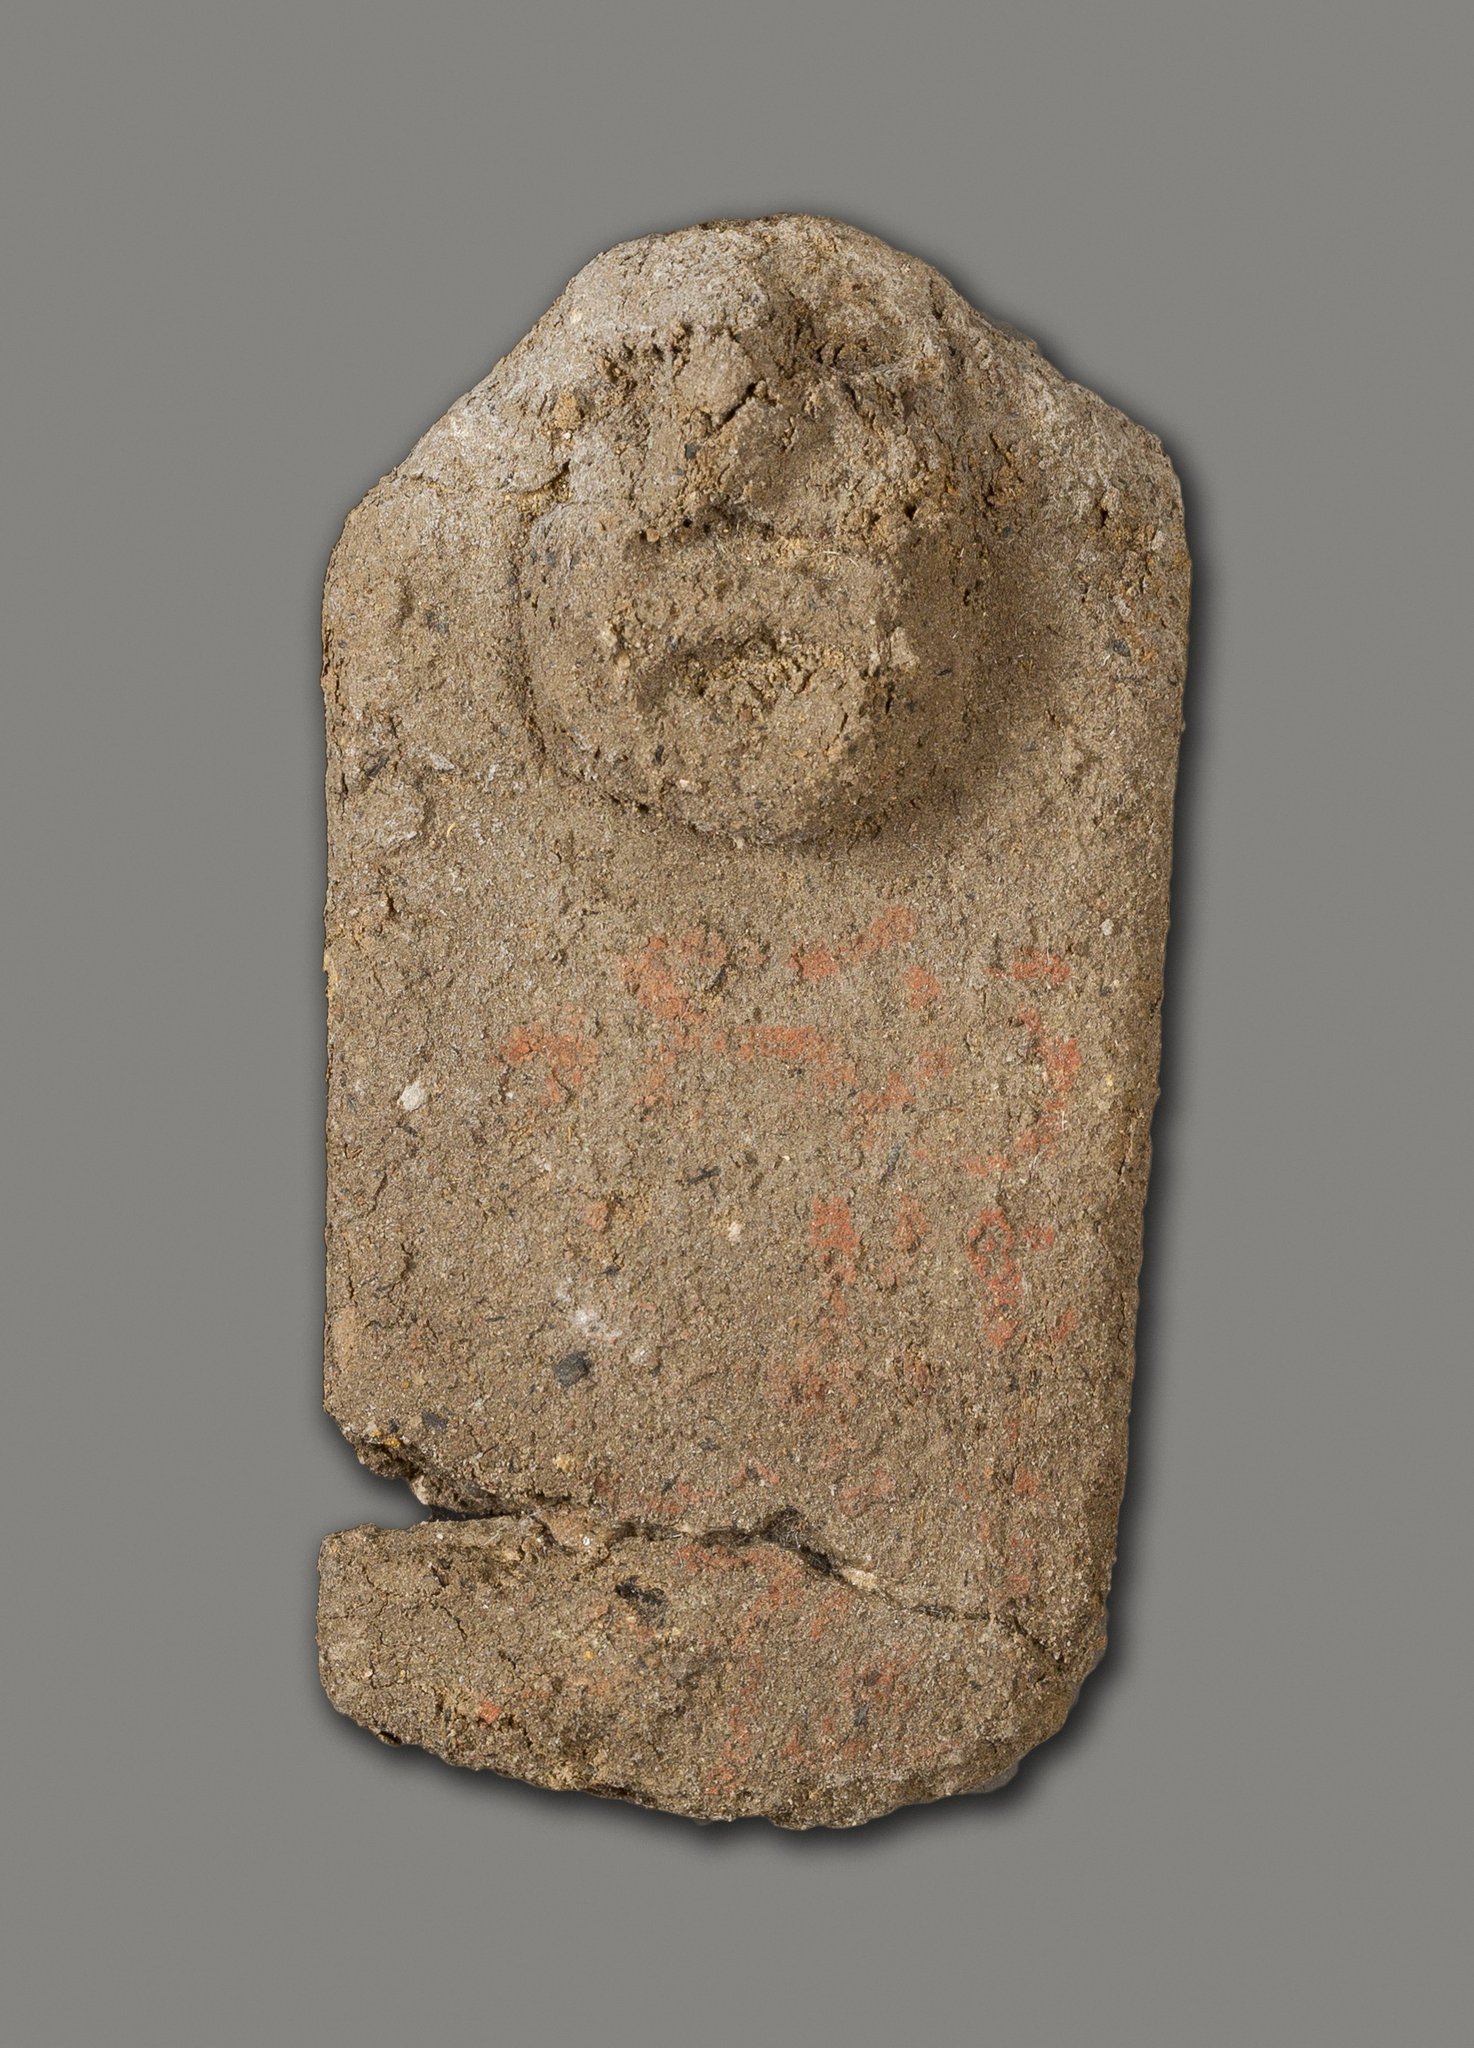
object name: figure, magical, execration, tablet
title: Magical Figure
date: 1802-1550 BCE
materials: clay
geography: egypt